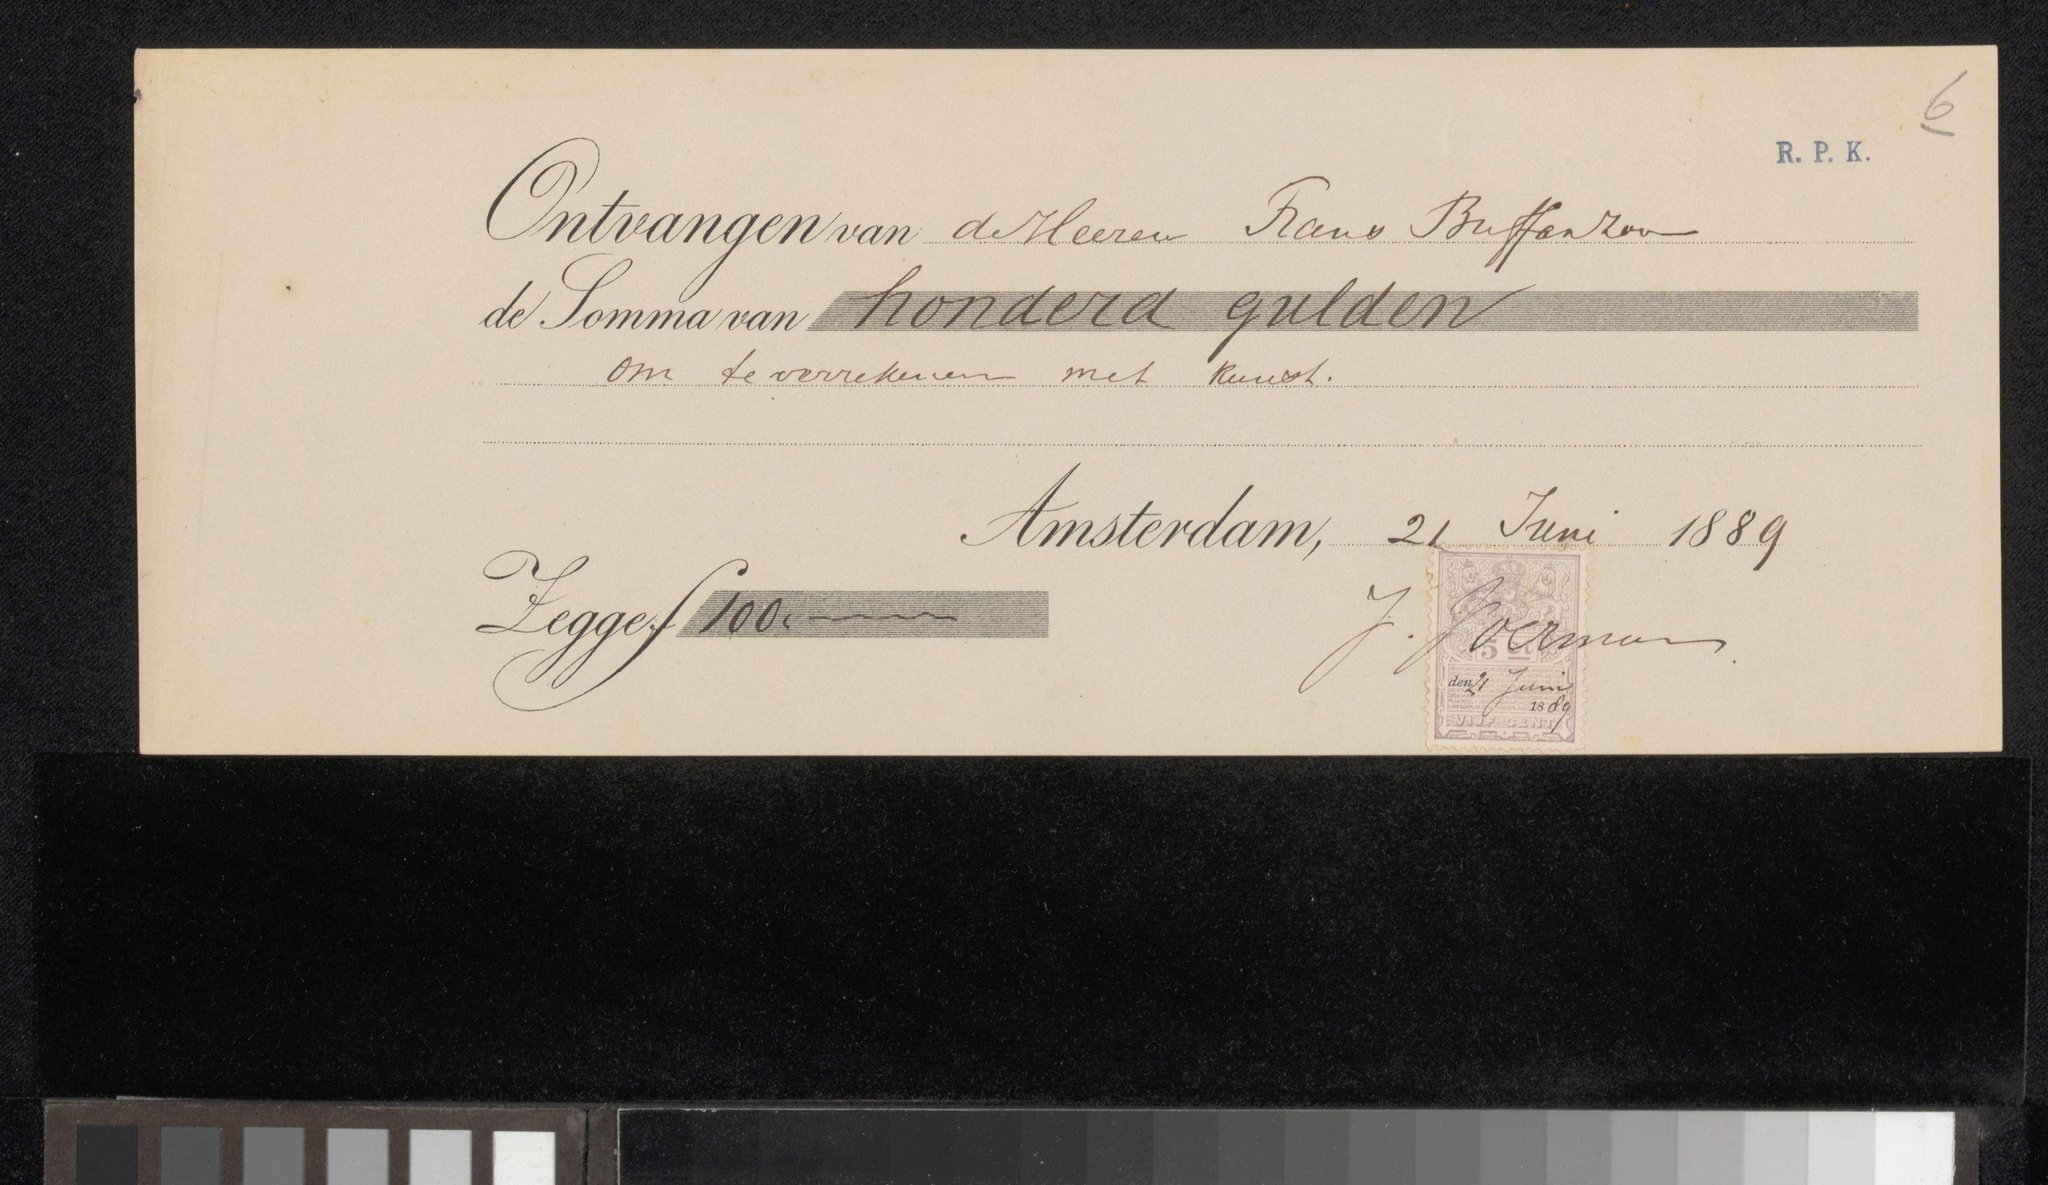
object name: ontvangstbewijs, kwitantie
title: Kwitantie voor Jan Voerman (1857-1941)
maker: jan voerman (1857-1941)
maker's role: draughtsman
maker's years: 1857-1941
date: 1889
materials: ink, paper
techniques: pen, printing, writing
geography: amsterdam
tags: money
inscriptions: collector's mark: Lugt 2233